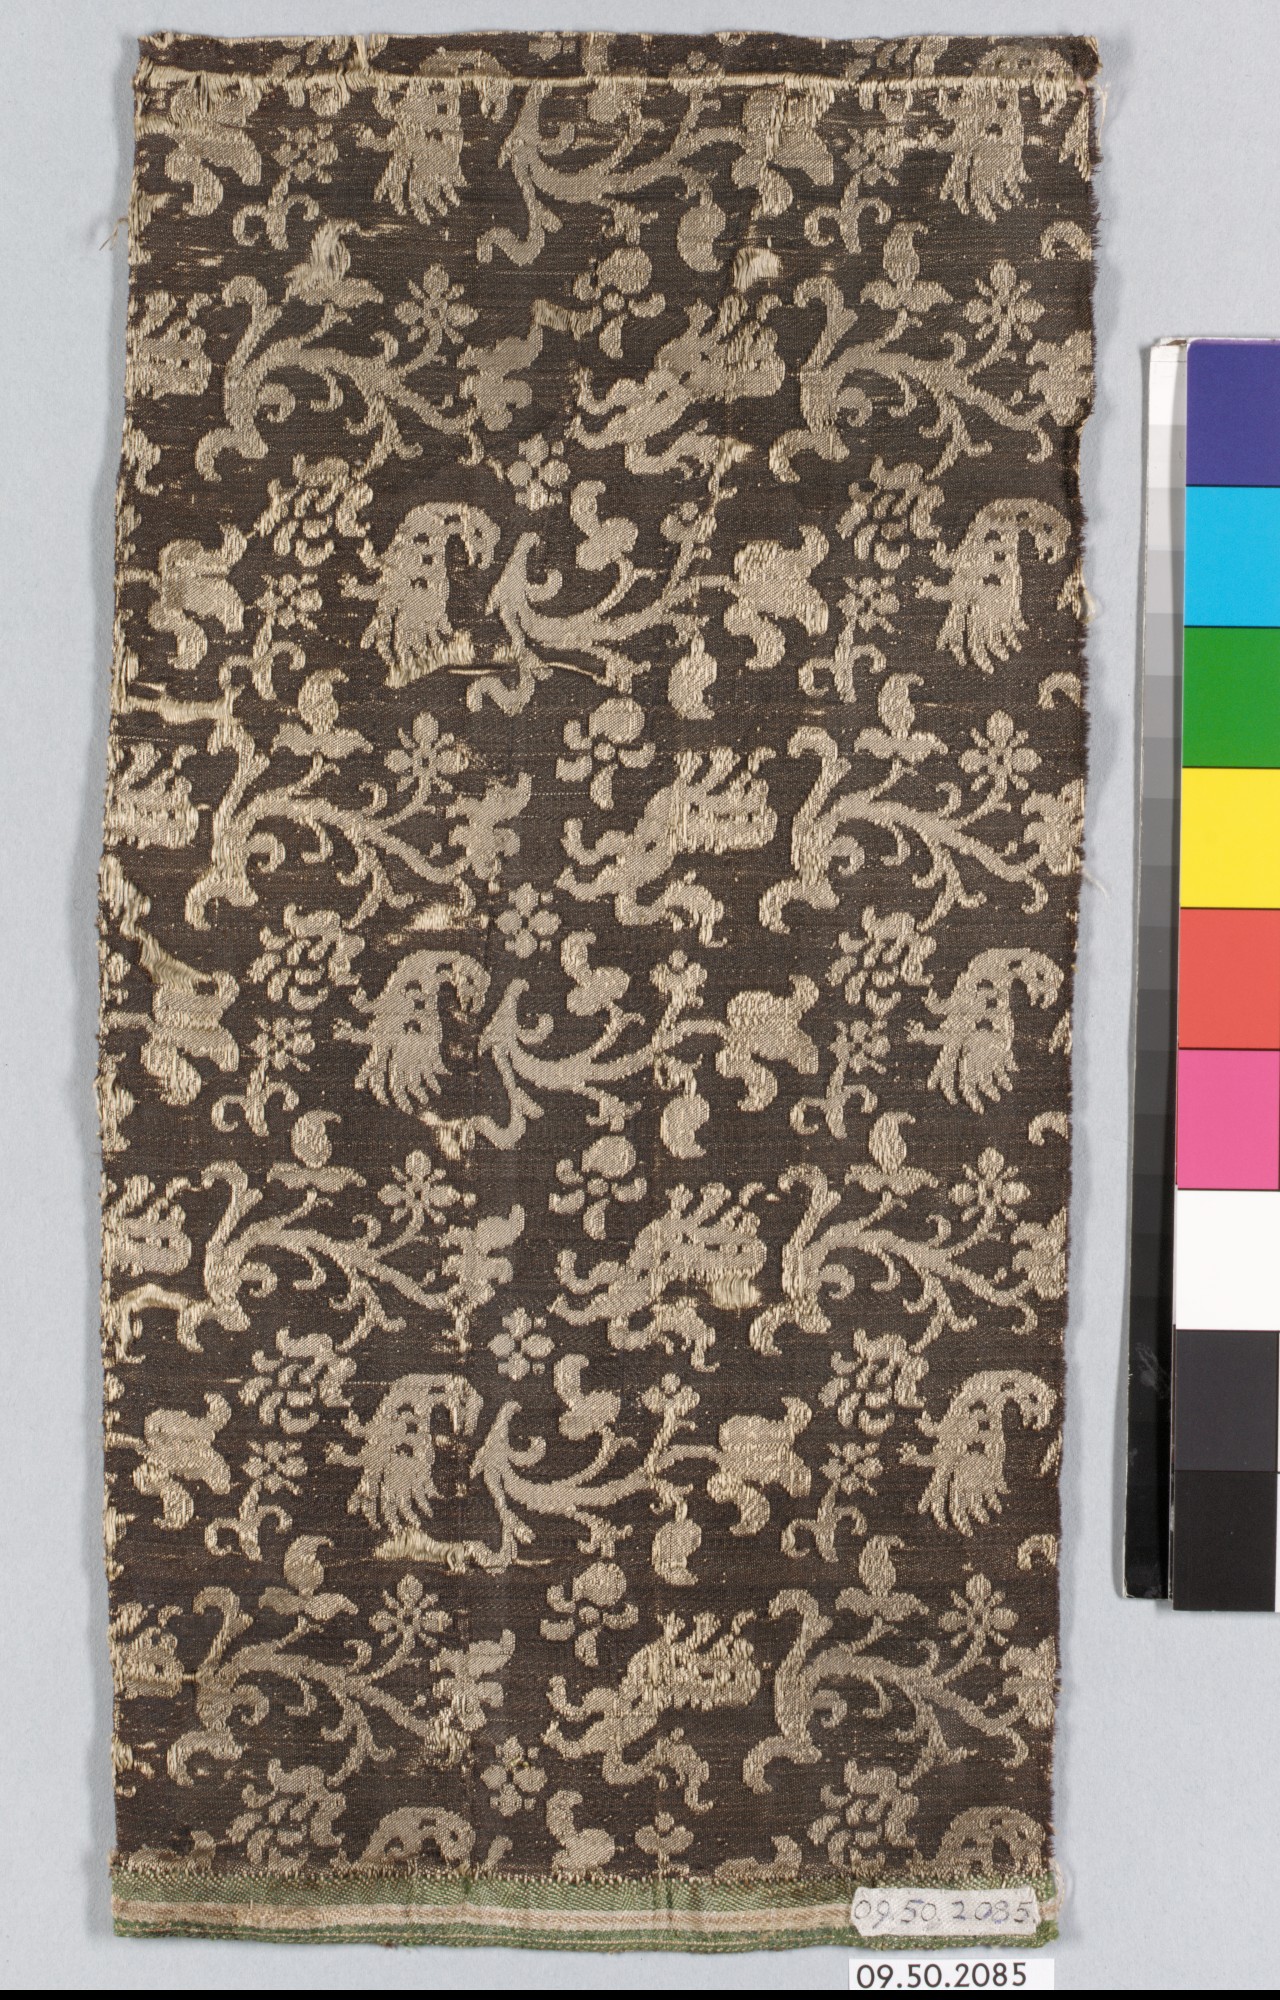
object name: fragment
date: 1501-1600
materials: silk